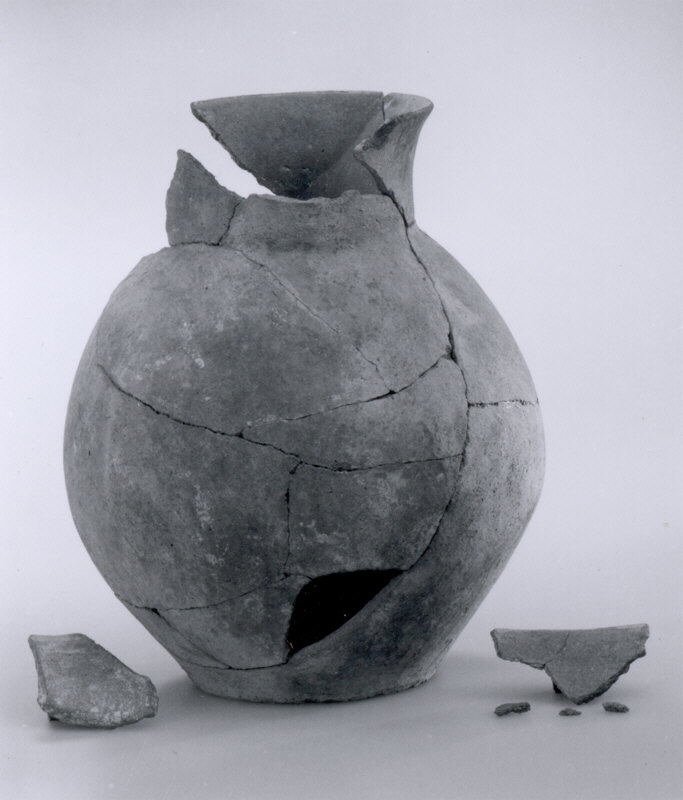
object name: jar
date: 3500-3300 BCE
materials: ceramic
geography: levant